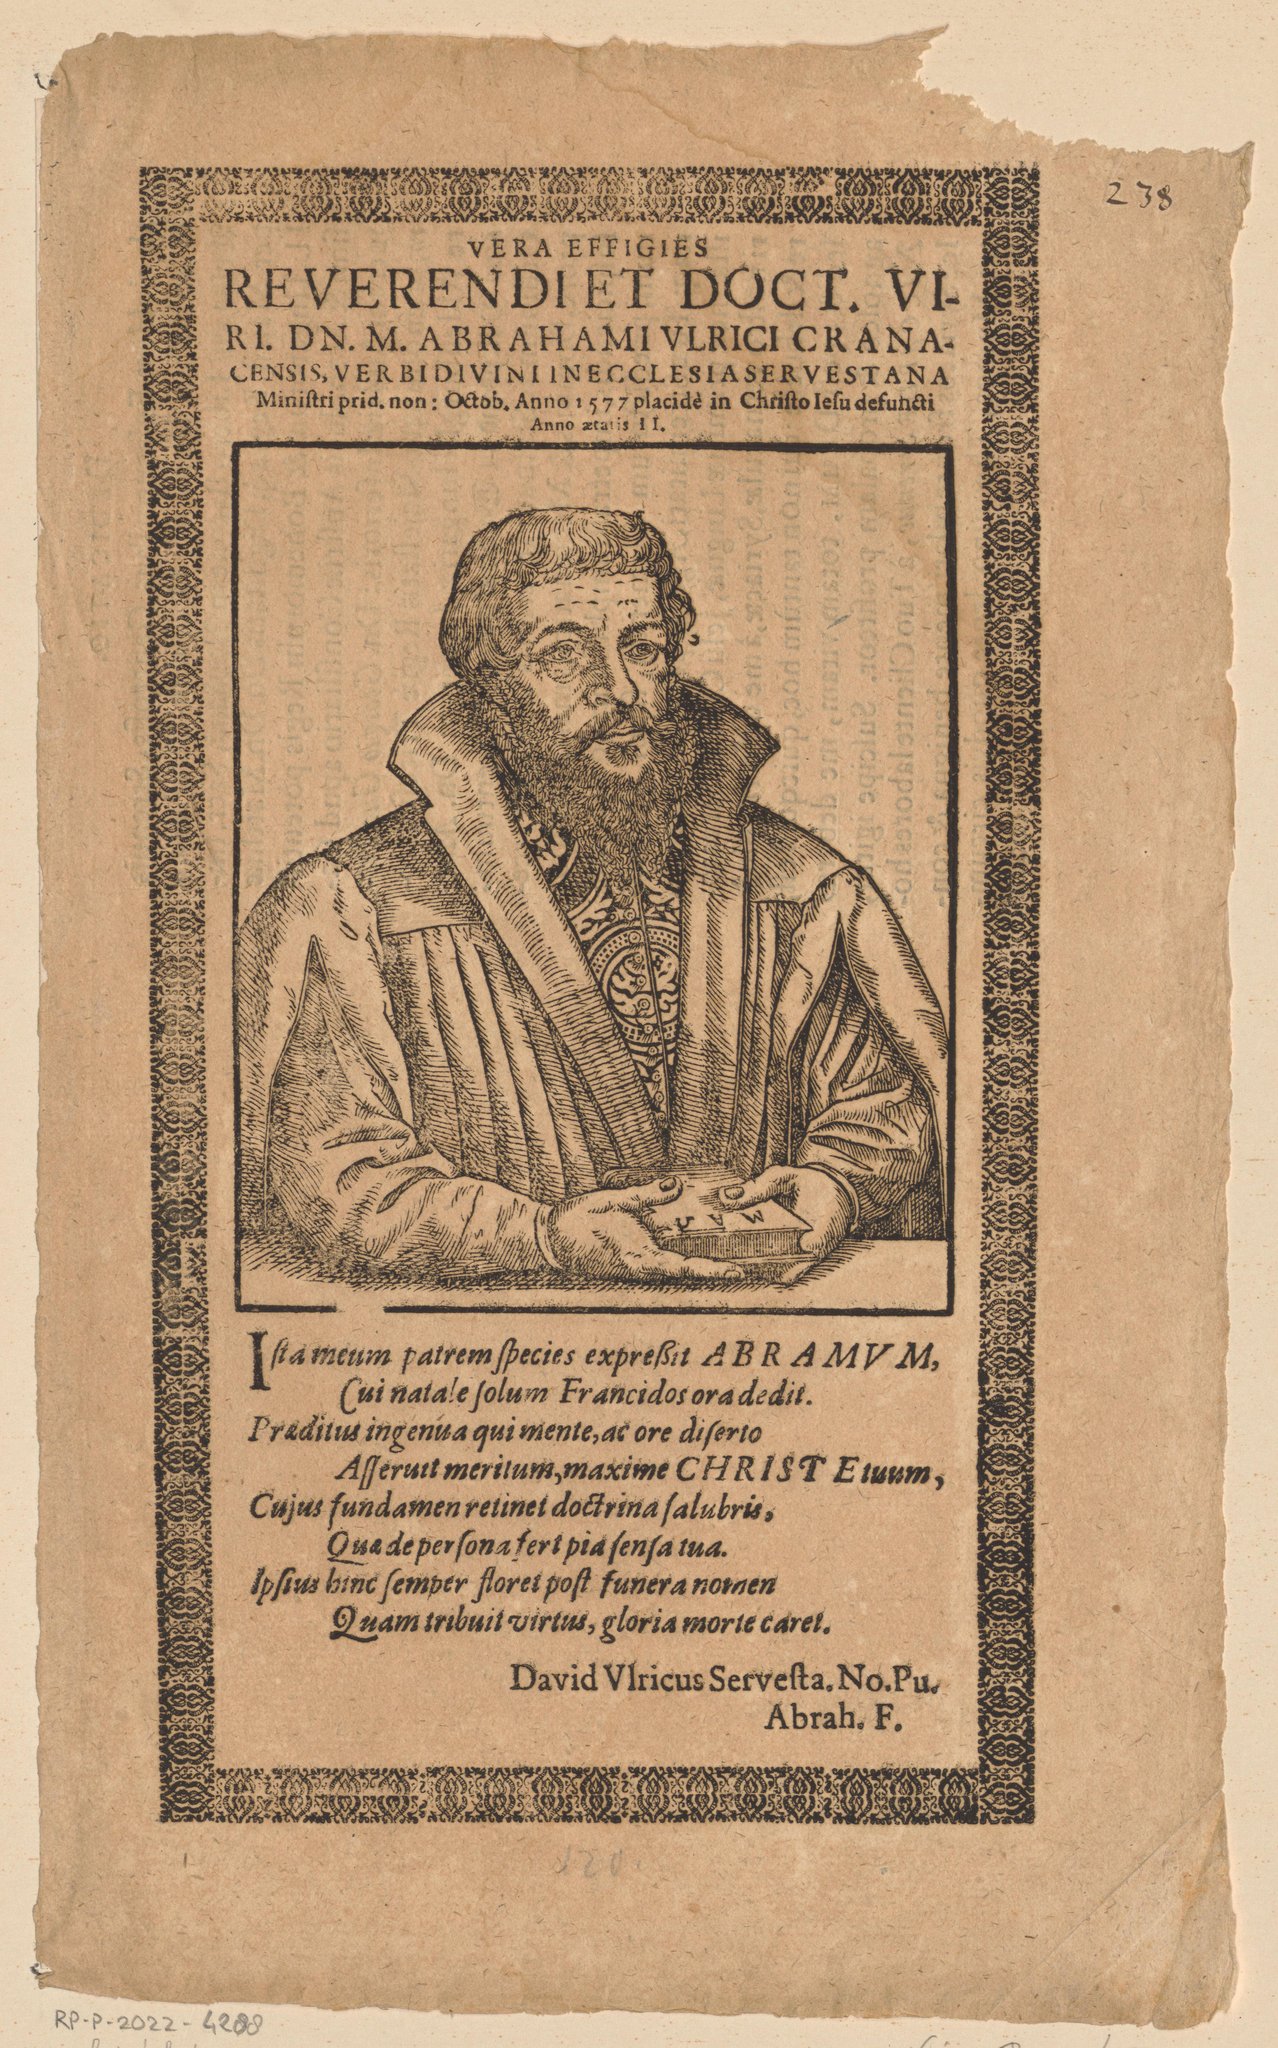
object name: print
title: Portret van Abraham Ulrich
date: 1577-1620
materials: paper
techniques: letterpress printing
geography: germany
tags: theologian, historical persons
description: Met boven en onder het portret een vijfregelig en een achtregelig onderschrift in het Latijn.